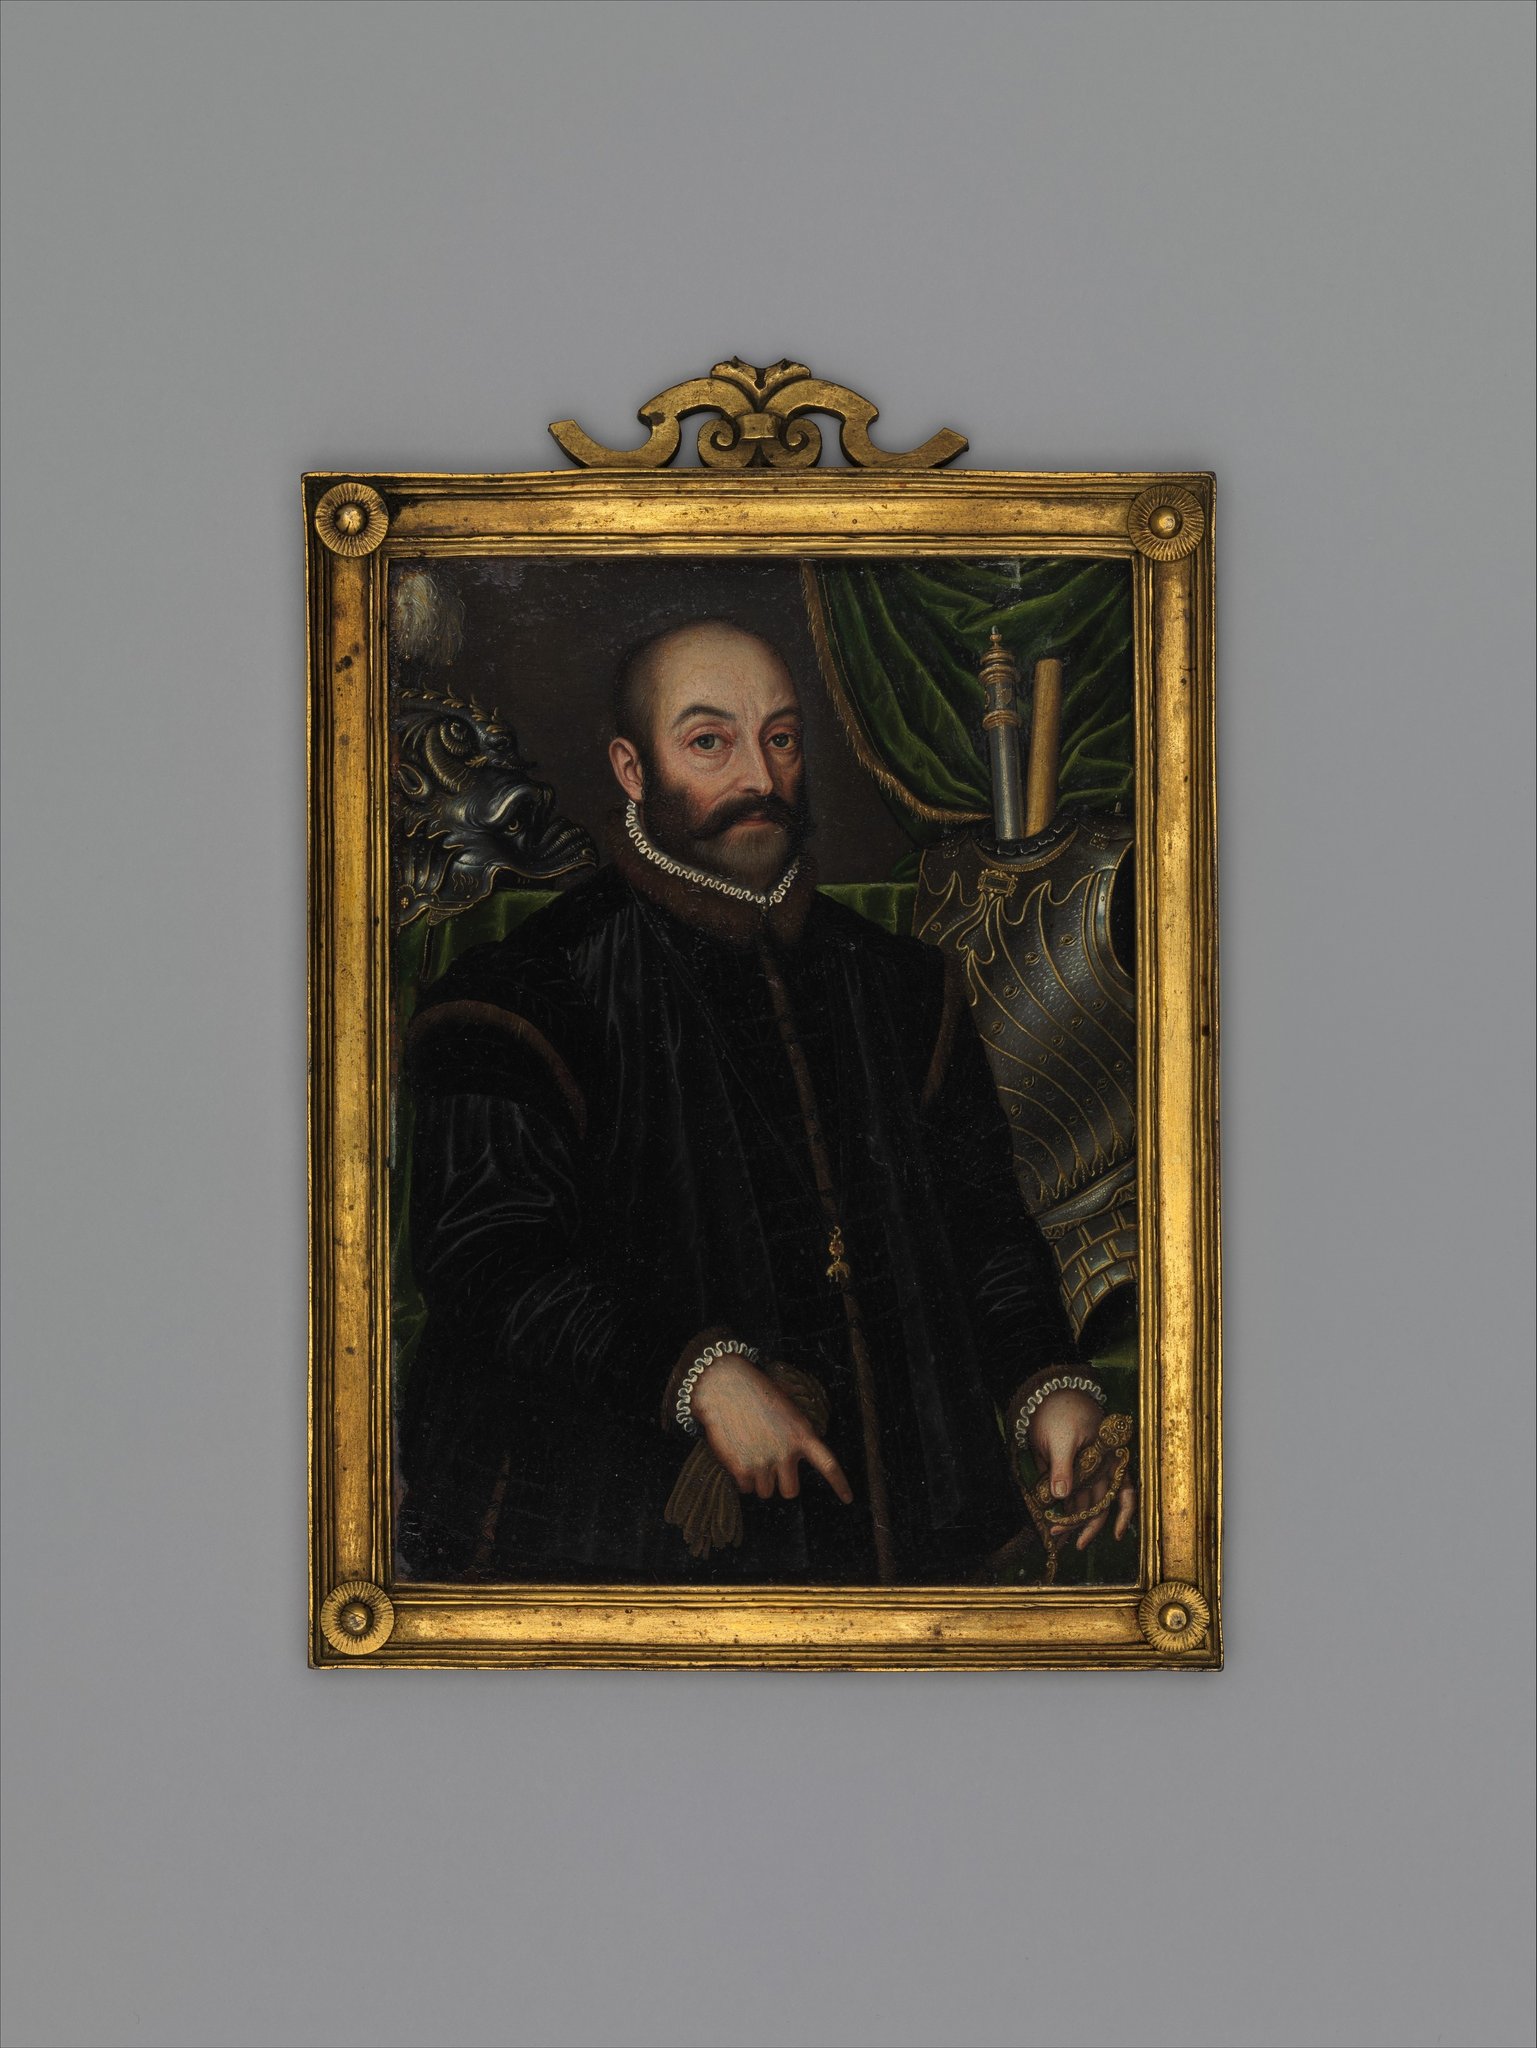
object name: painting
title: Guidobaldo II della Rovere, Duke of Urbino (1514–1574), With his Armor by Filippo Negroli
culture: italian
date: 1580-1585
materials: copper, oil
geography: italy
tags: armor,men,portraits